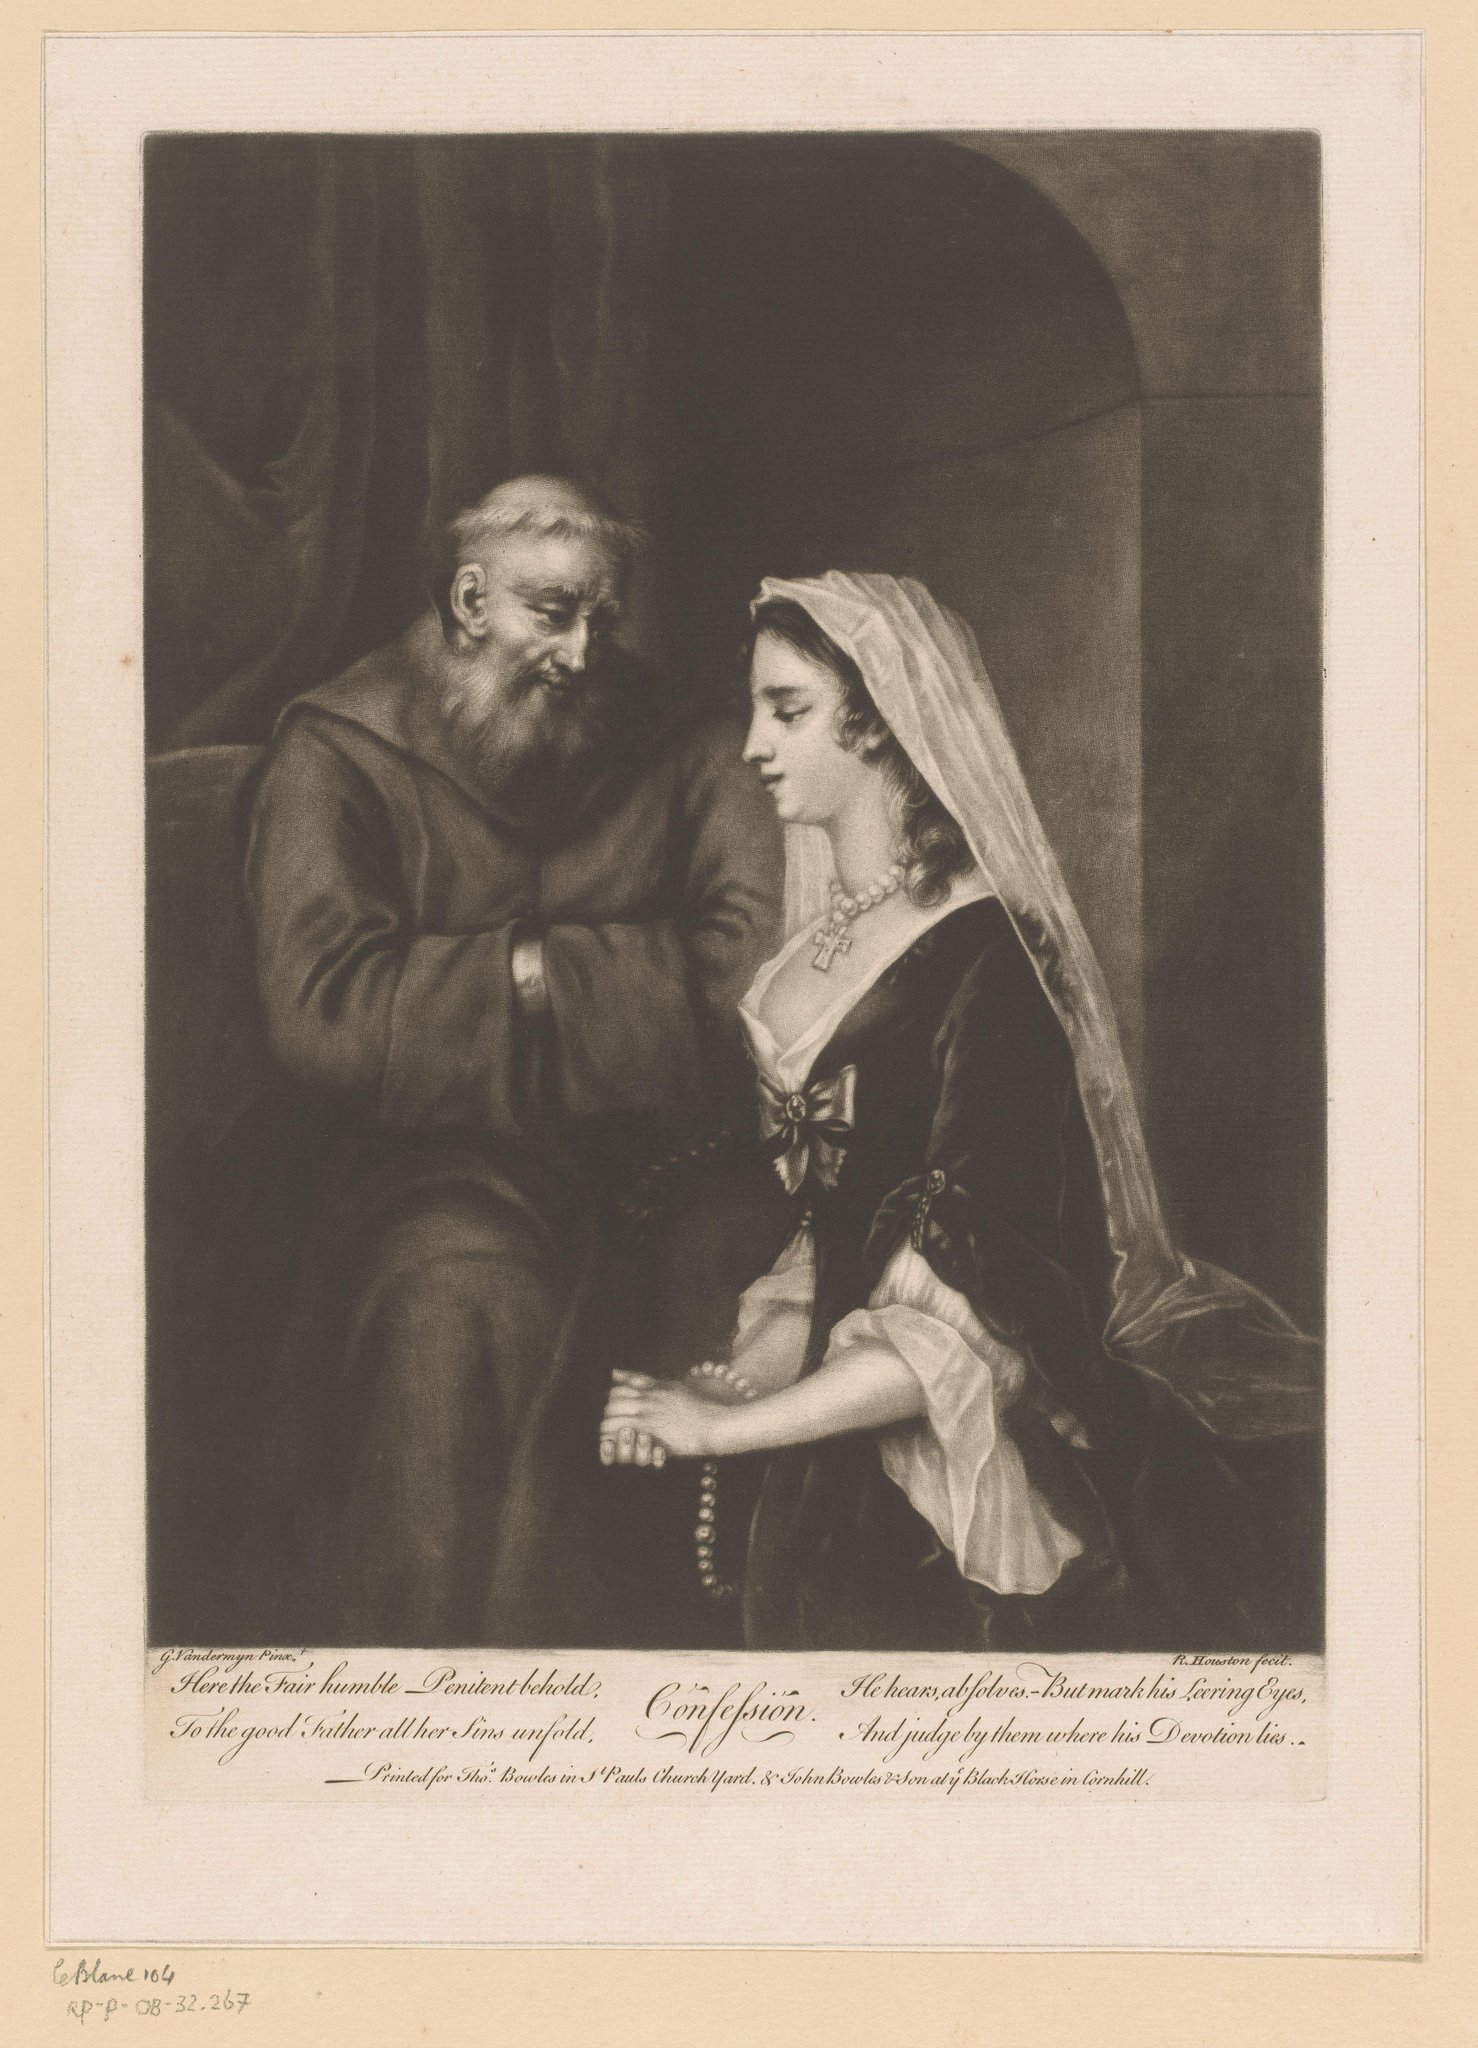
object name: print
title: Confession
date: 1731-1766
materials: paper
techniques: mezzotint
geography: london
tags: adolescent, young woman, maiden, monk(s), friar(s), confession; 'confessione sacramentale' (ripa) ~ the third of the seven sacraments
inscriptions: collector's mark: Lugt 240